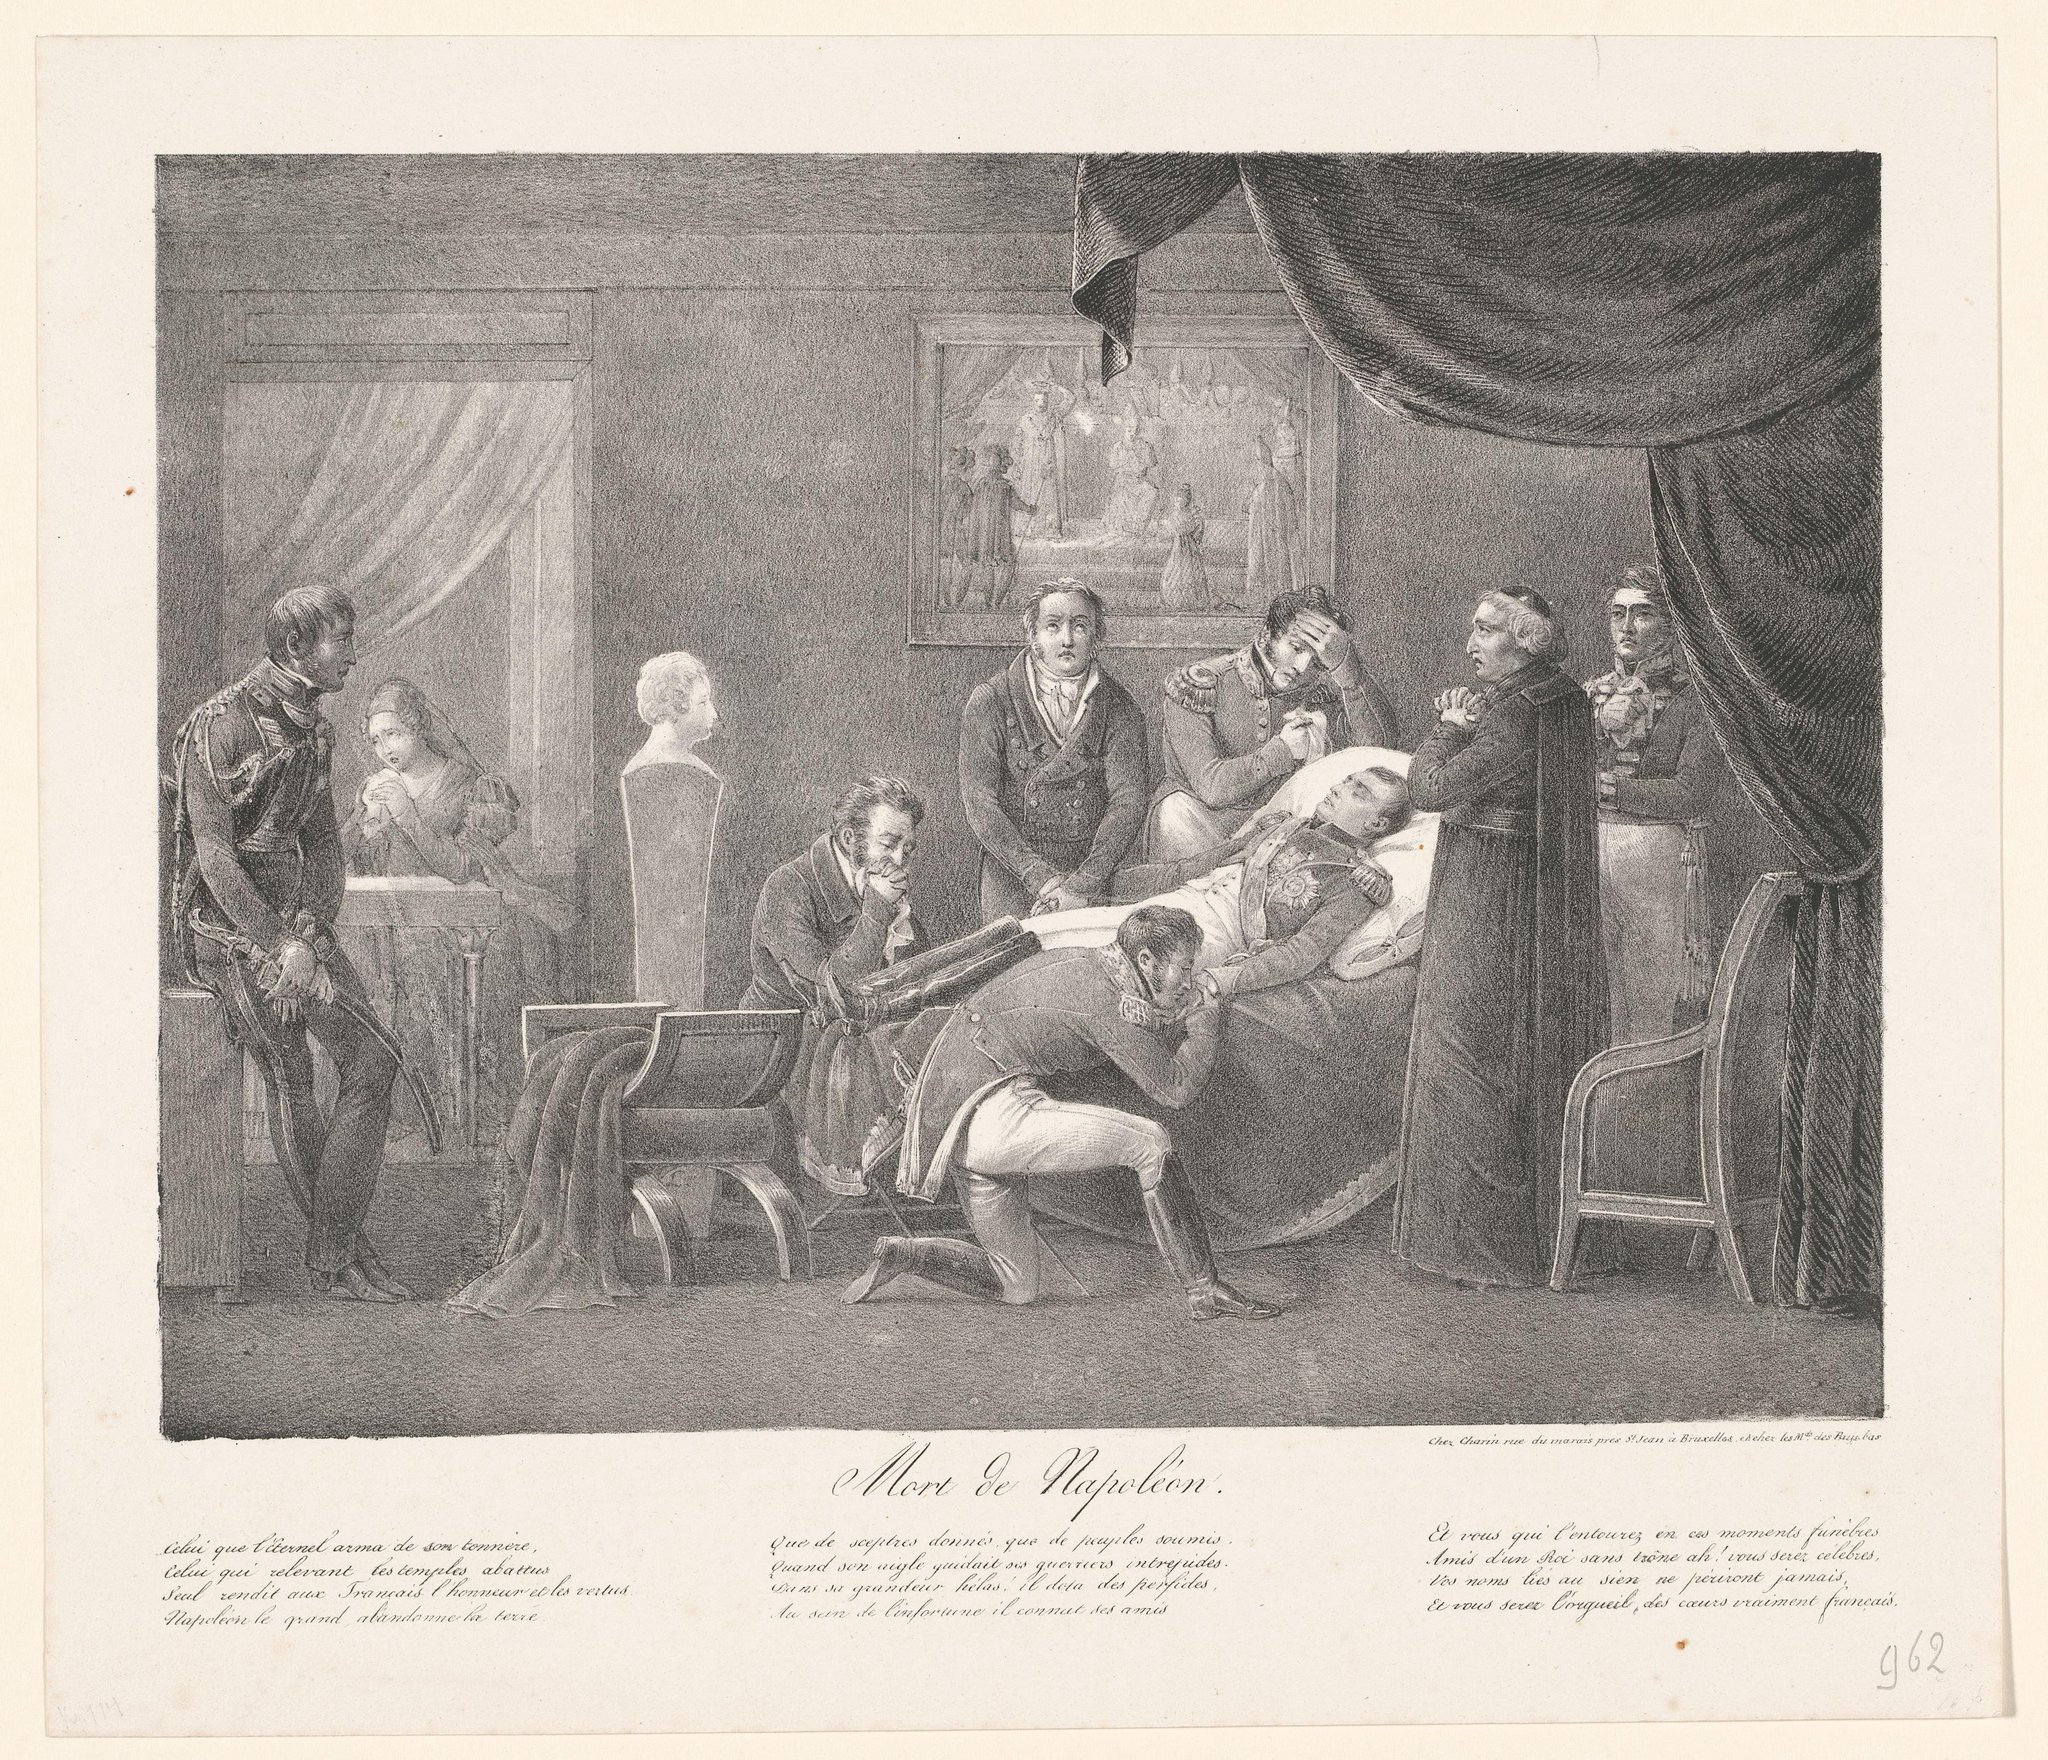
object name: print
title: Dood van Napoleon, 1821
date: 1821-1825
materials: paper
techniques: lithograph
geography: brussels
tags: napoleon i (emperor of the french), deathbed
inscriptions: collector's mark: Lugt 2228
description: Dood van Napoleon, 5 mei 1821. Onderaan in drie kolommen het gedicht 'Celui qui l'éternel'.